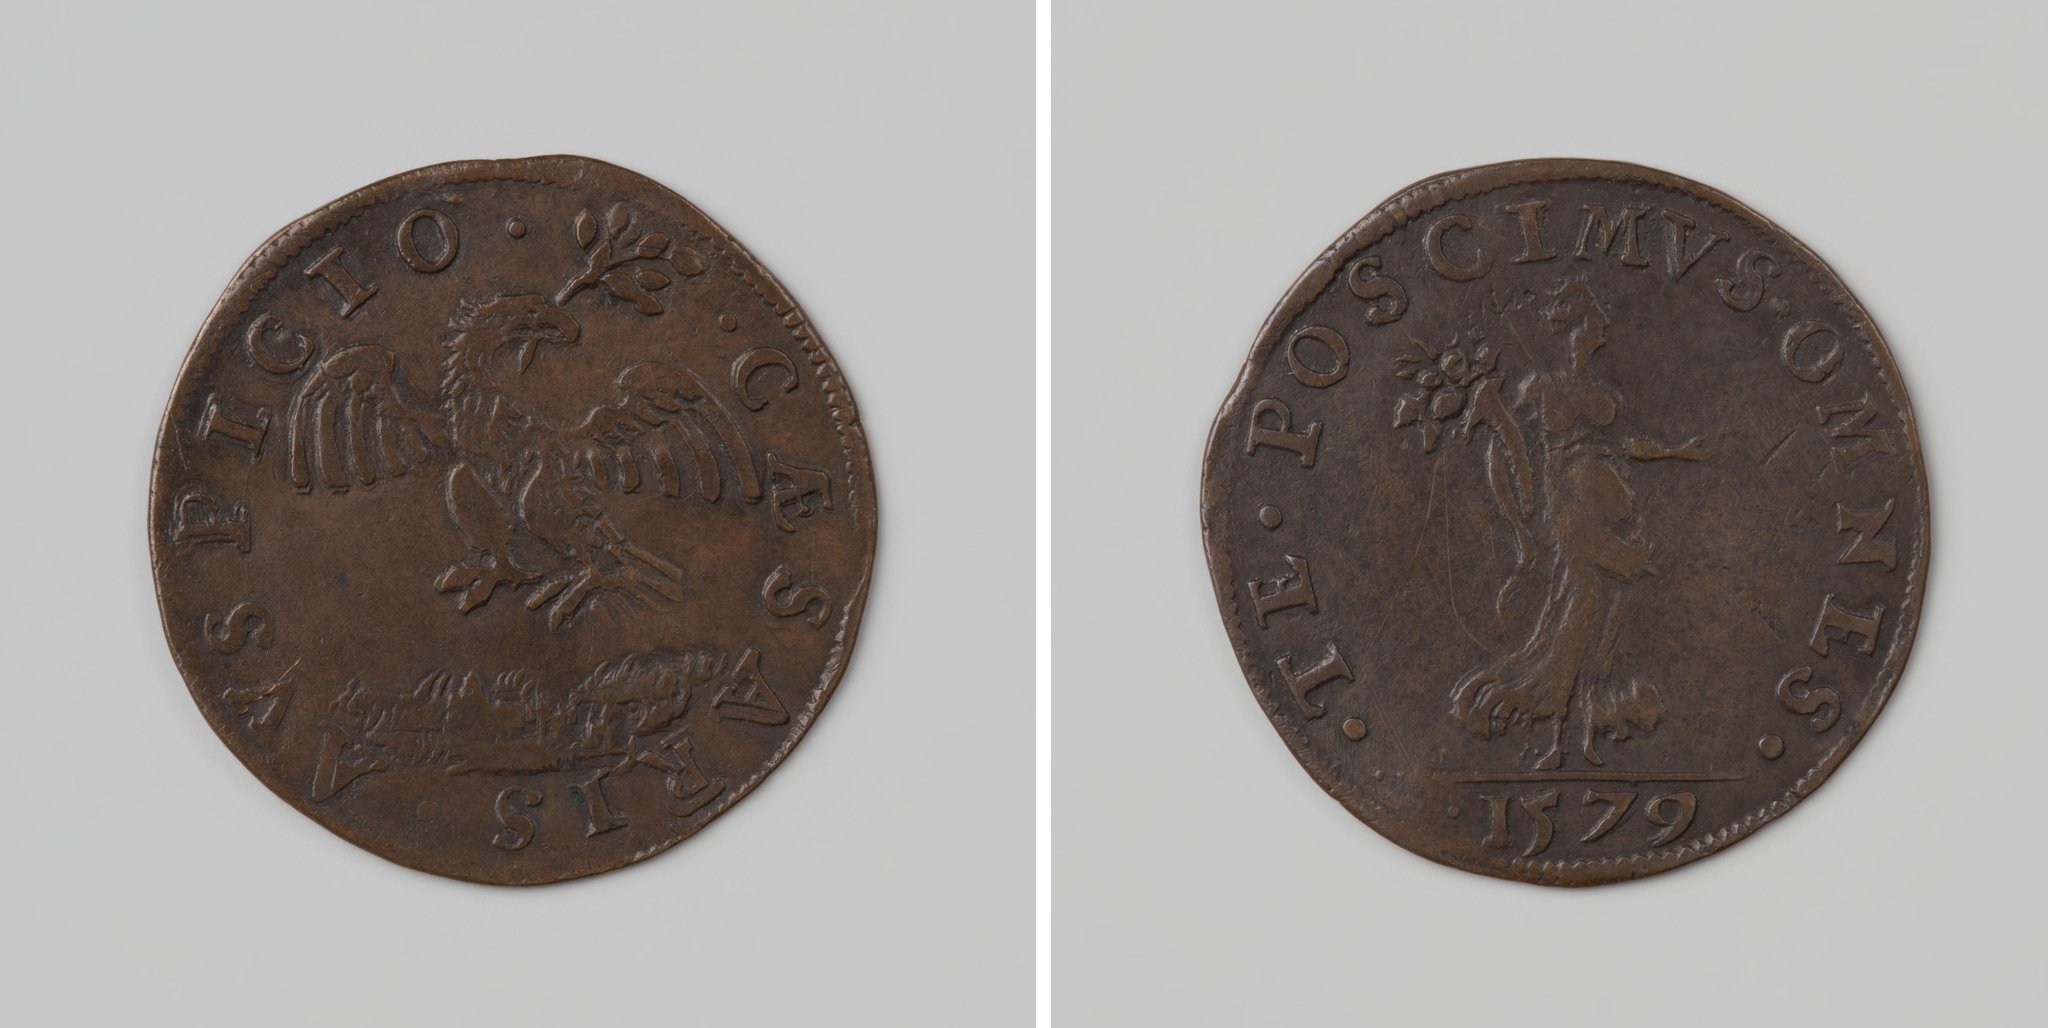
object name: jeton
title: Vredesonderhandelingen te Keulen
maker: Anonymous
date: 1579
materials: copper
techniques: striking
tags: cologne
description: Koperen penning. Voorzijde: adelaar met olijftak in bek binnen omschrift. Keerzijde: staande vrouw, voorstellende de Vrede, houdt linkerarm uitgestrekt en in rechterhand gevulde hoorn van overvloed binnen omschrift.